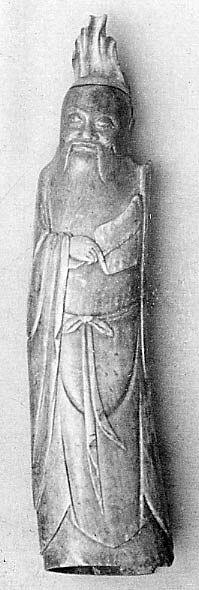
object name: figure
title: Carved Figure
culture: chinese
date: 1401-1500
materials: ivory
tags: men